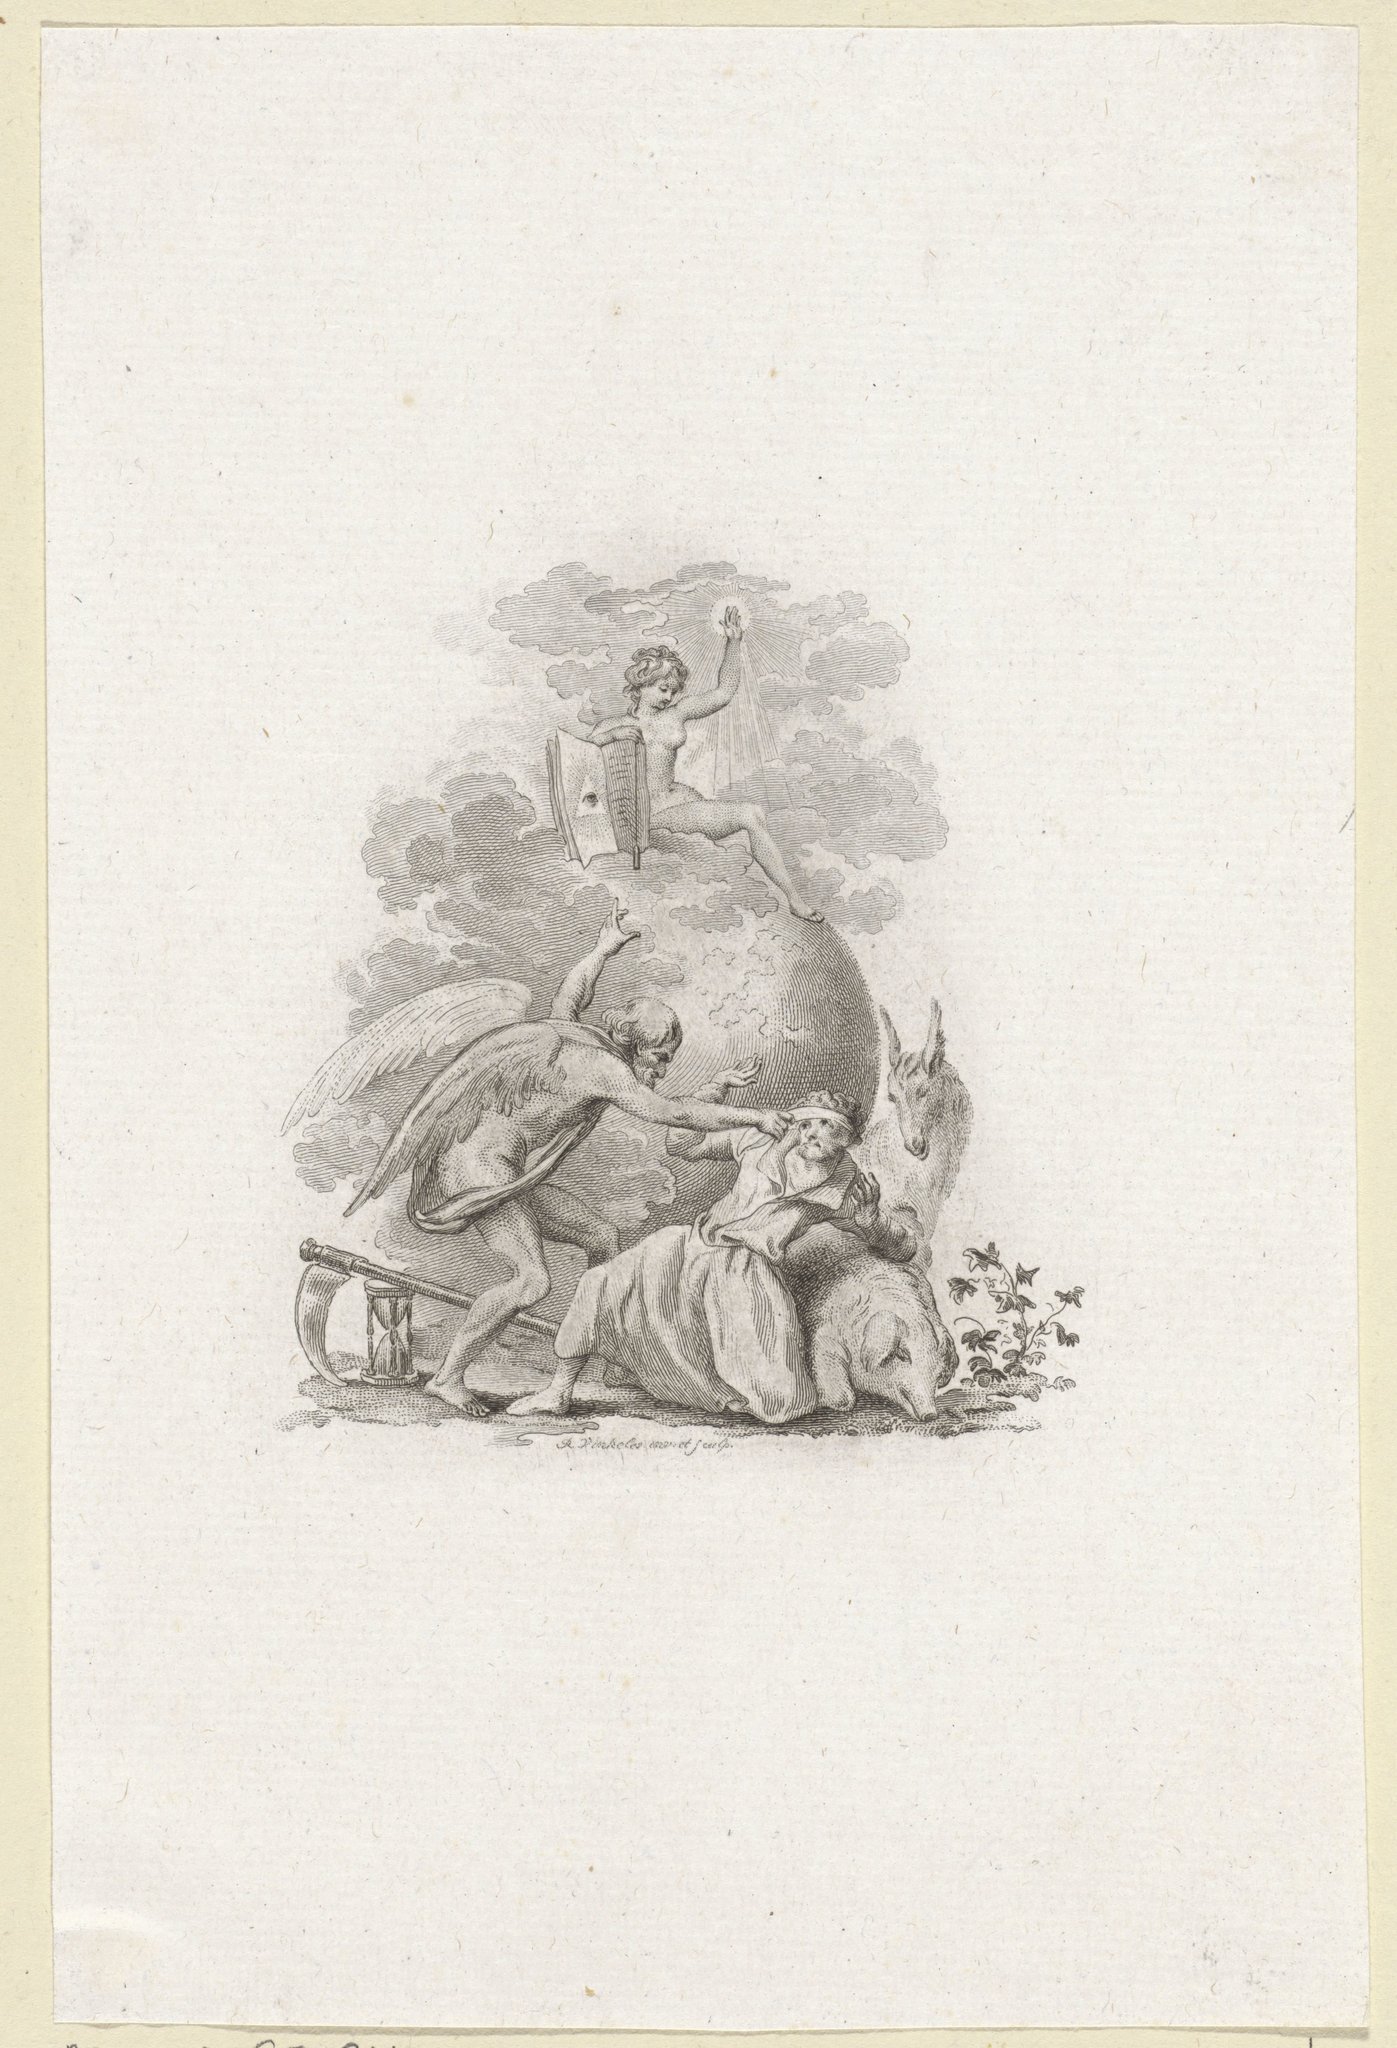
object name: print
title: Titelpagina voor: Salchli, 'Het Kwaad', 1798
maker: reinier vinkeles (i)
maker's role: draughtsman, print maker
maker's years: 1741-1816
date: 1798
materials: paper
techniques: engraving, etching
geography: amsterdam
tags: earth, world as celestial body, time revealing truth; time carrying truth aloft (+ variant), father time, man with wings and scythe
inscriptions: collector's mark: Lugt 240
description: Proefdruk van titelpagina voor: Salchli. Het Kwaad. Amsterdam: Johannes Allart, 1798.